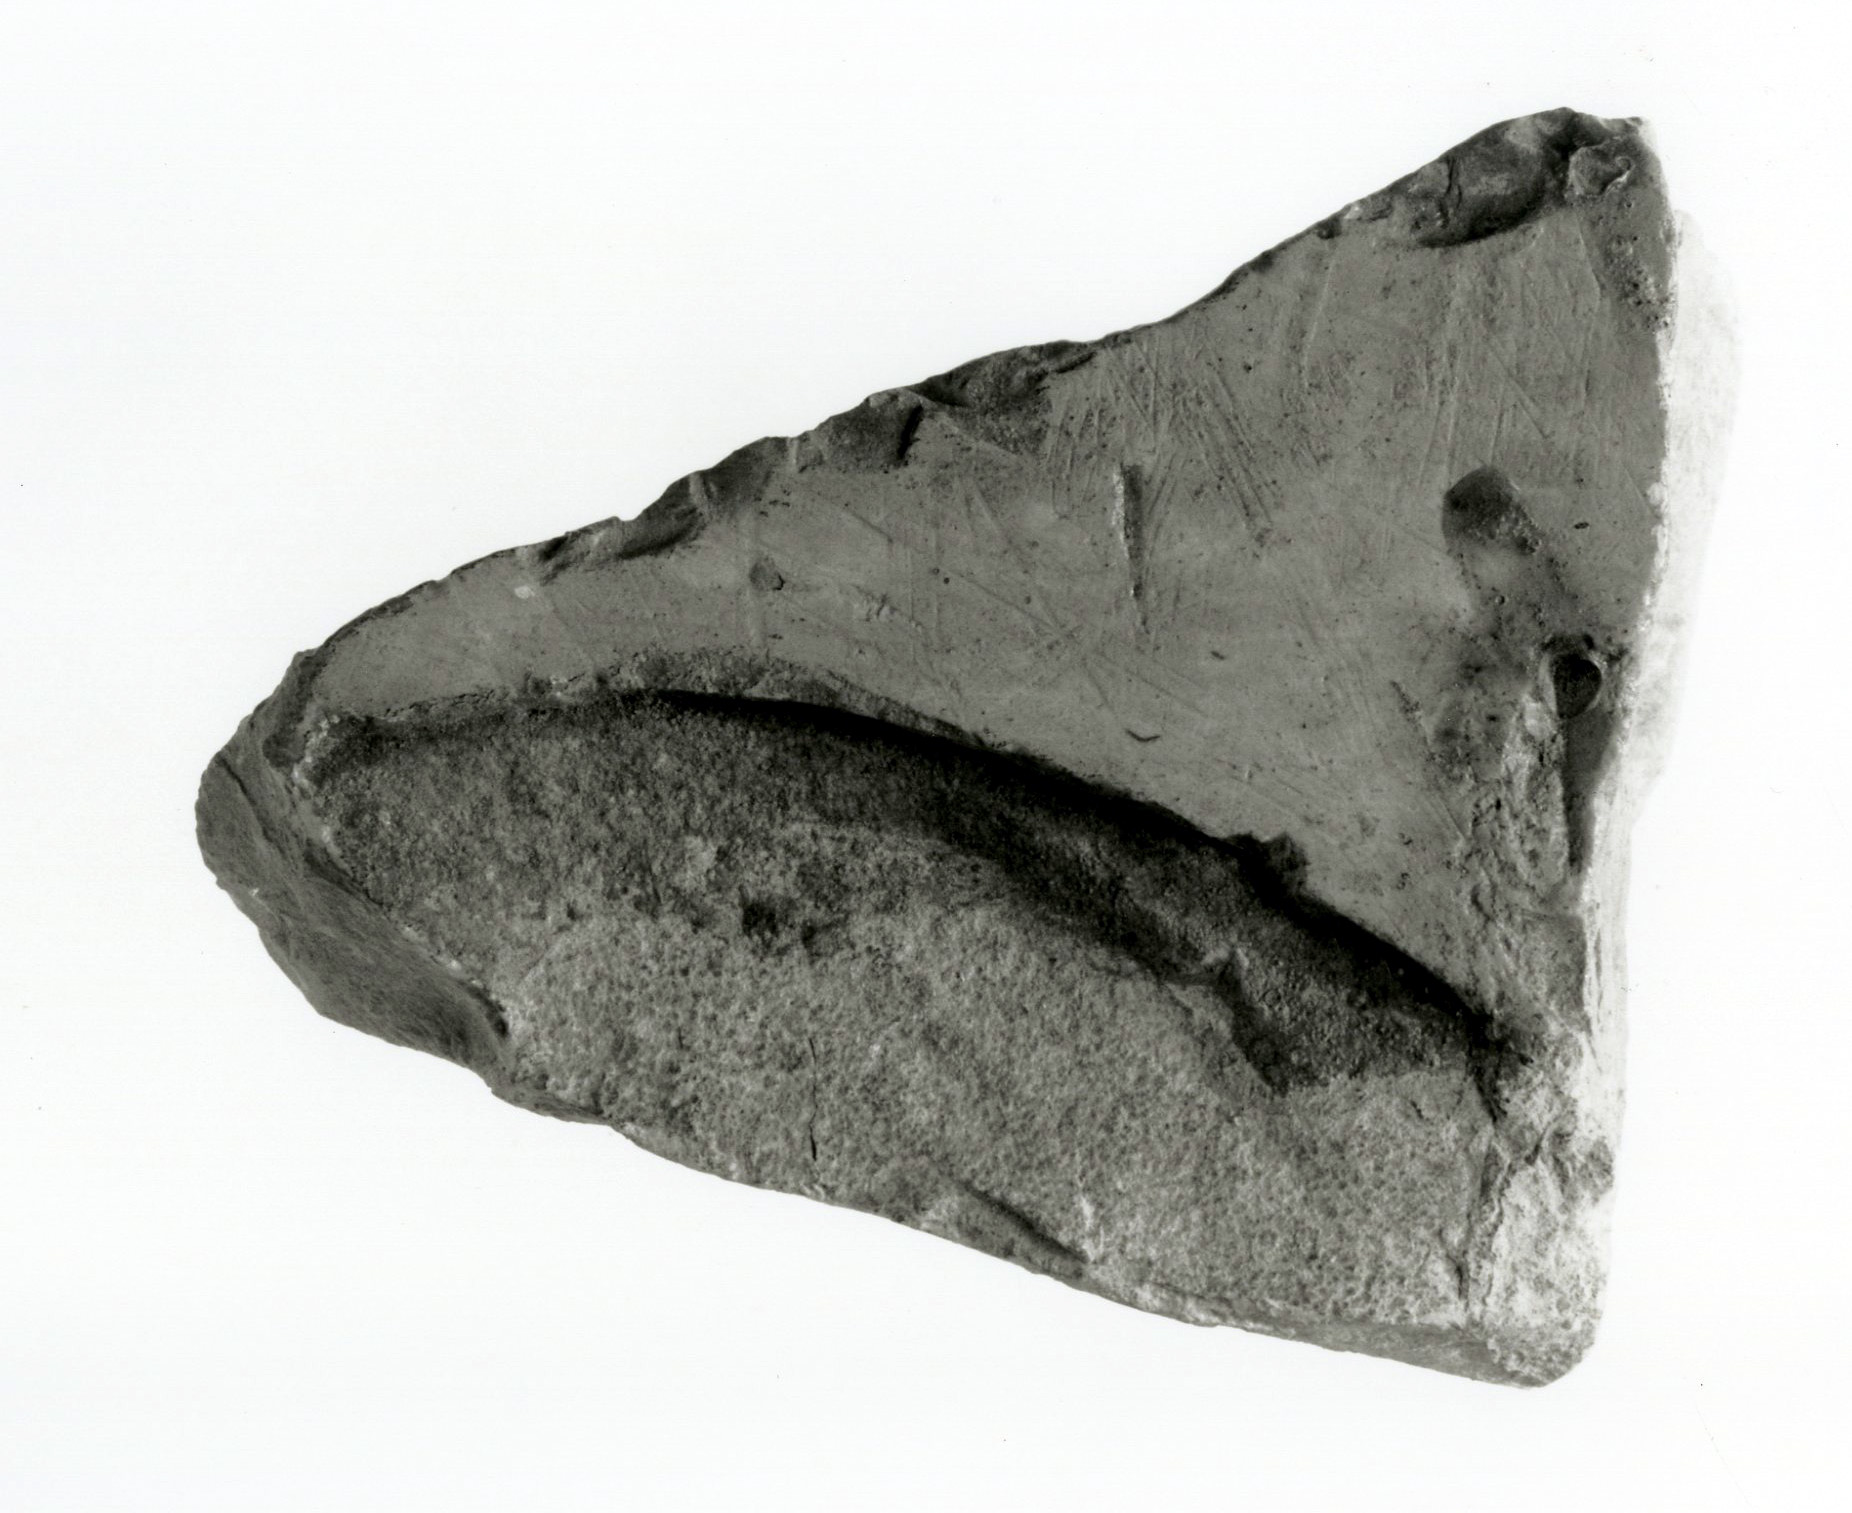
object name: relief, tomb of nespekashuty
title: Sunk relief fragment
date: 664-610 BCE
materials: limestone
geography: egypt